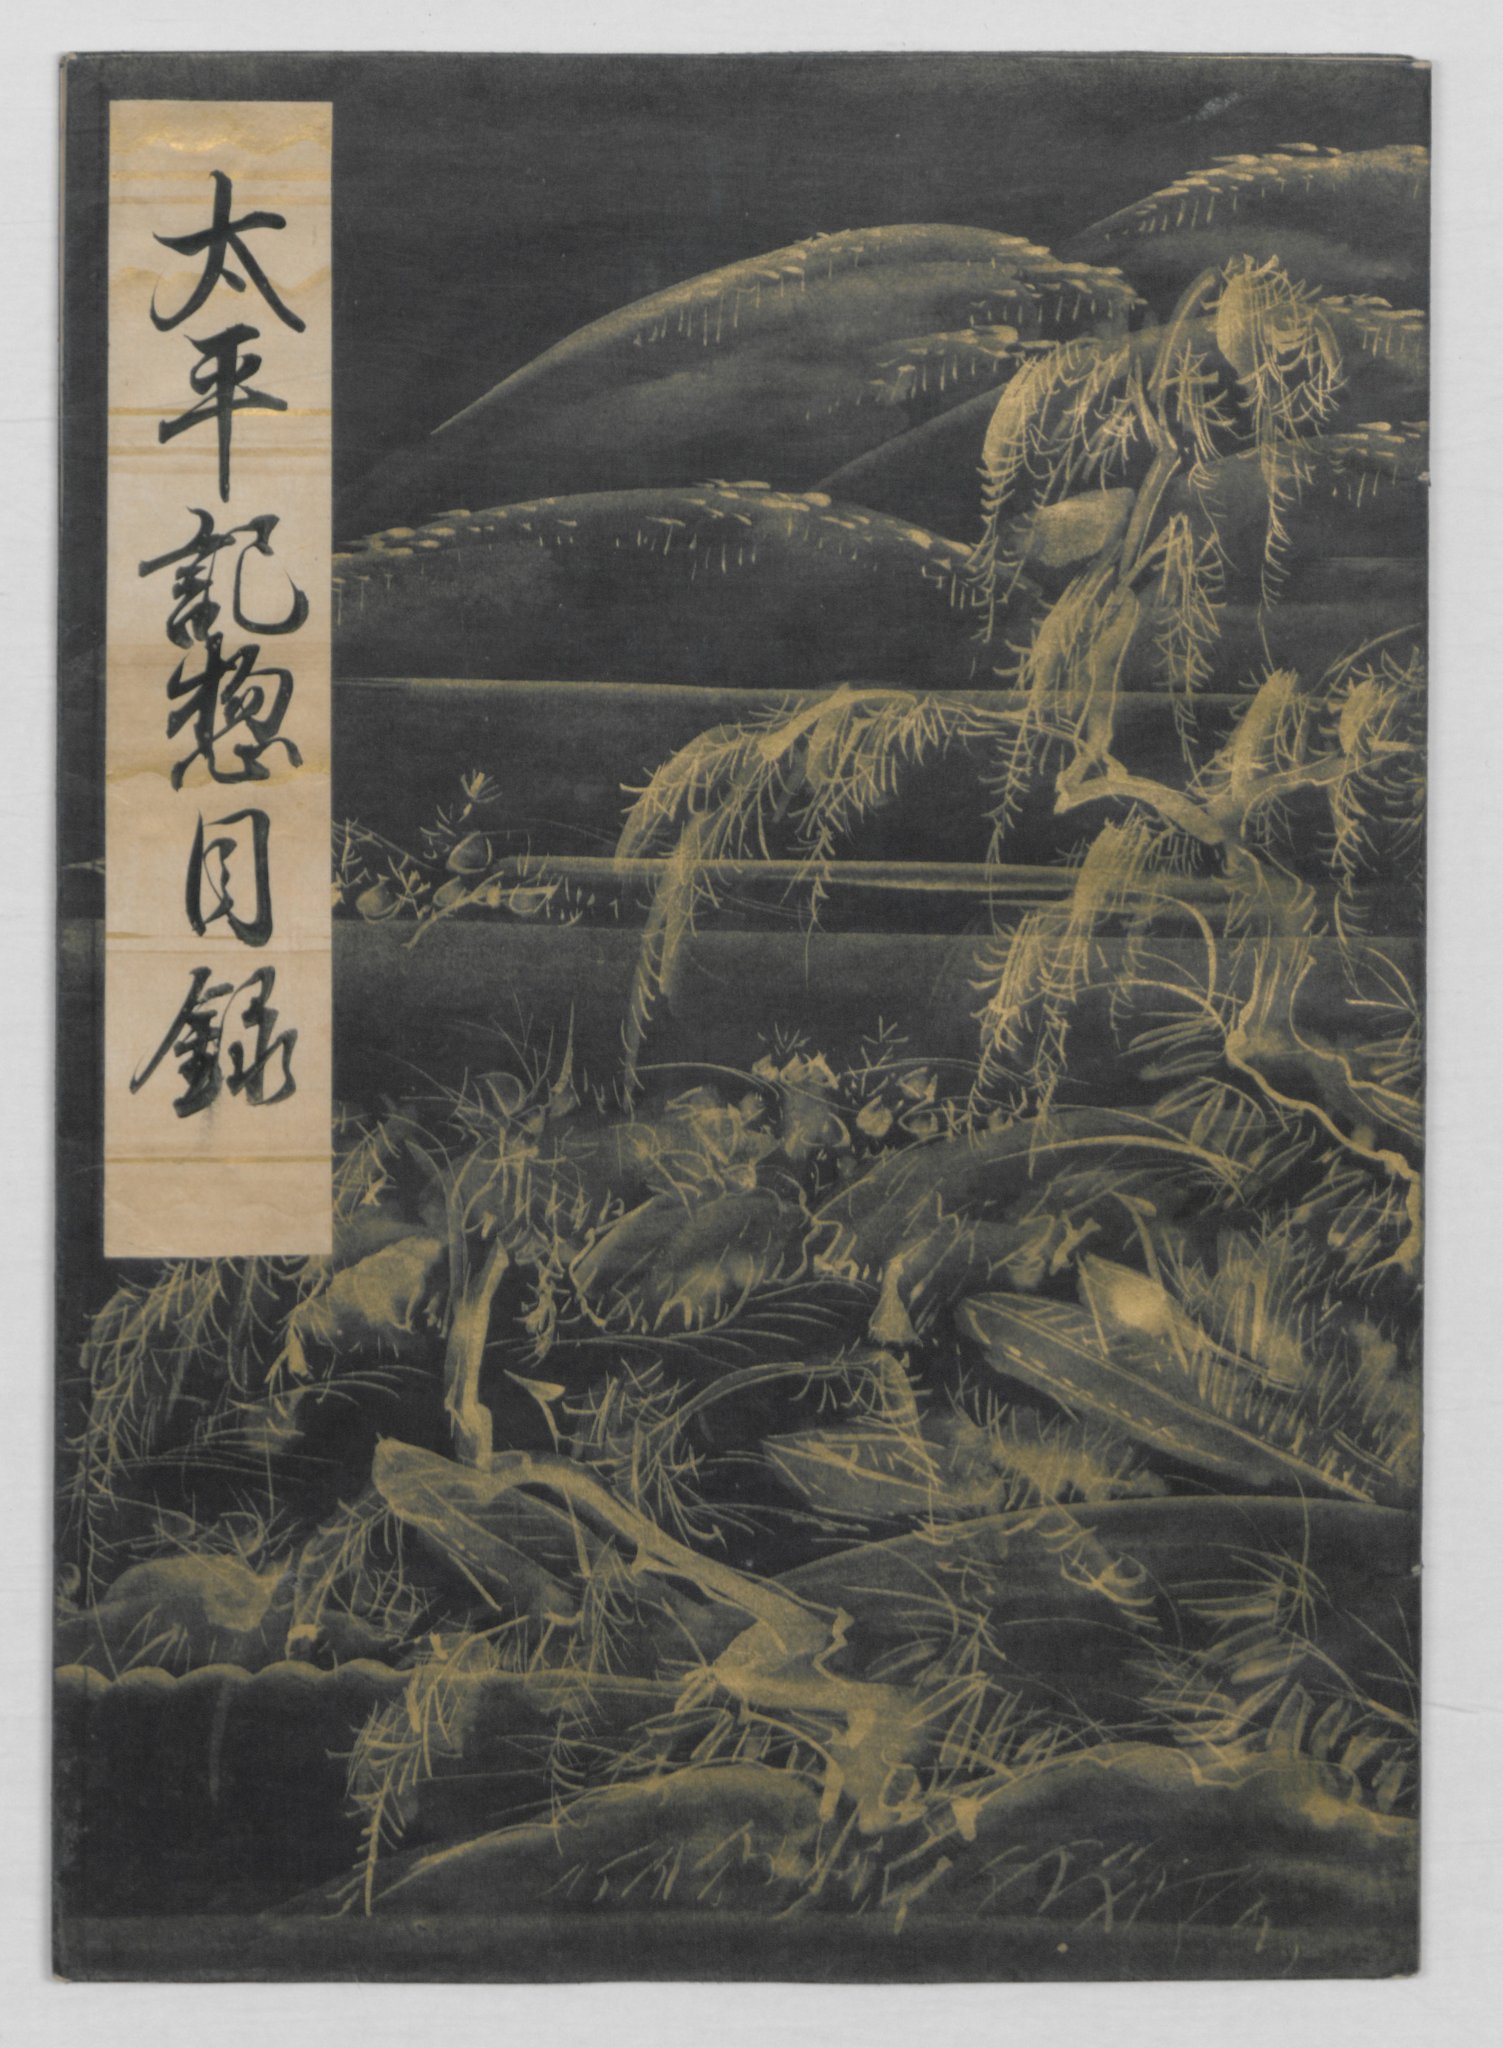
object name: book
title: Manuscript Version of “The Chronicle of Great Peace”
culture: japanese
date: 1701-1800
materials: ink, paper